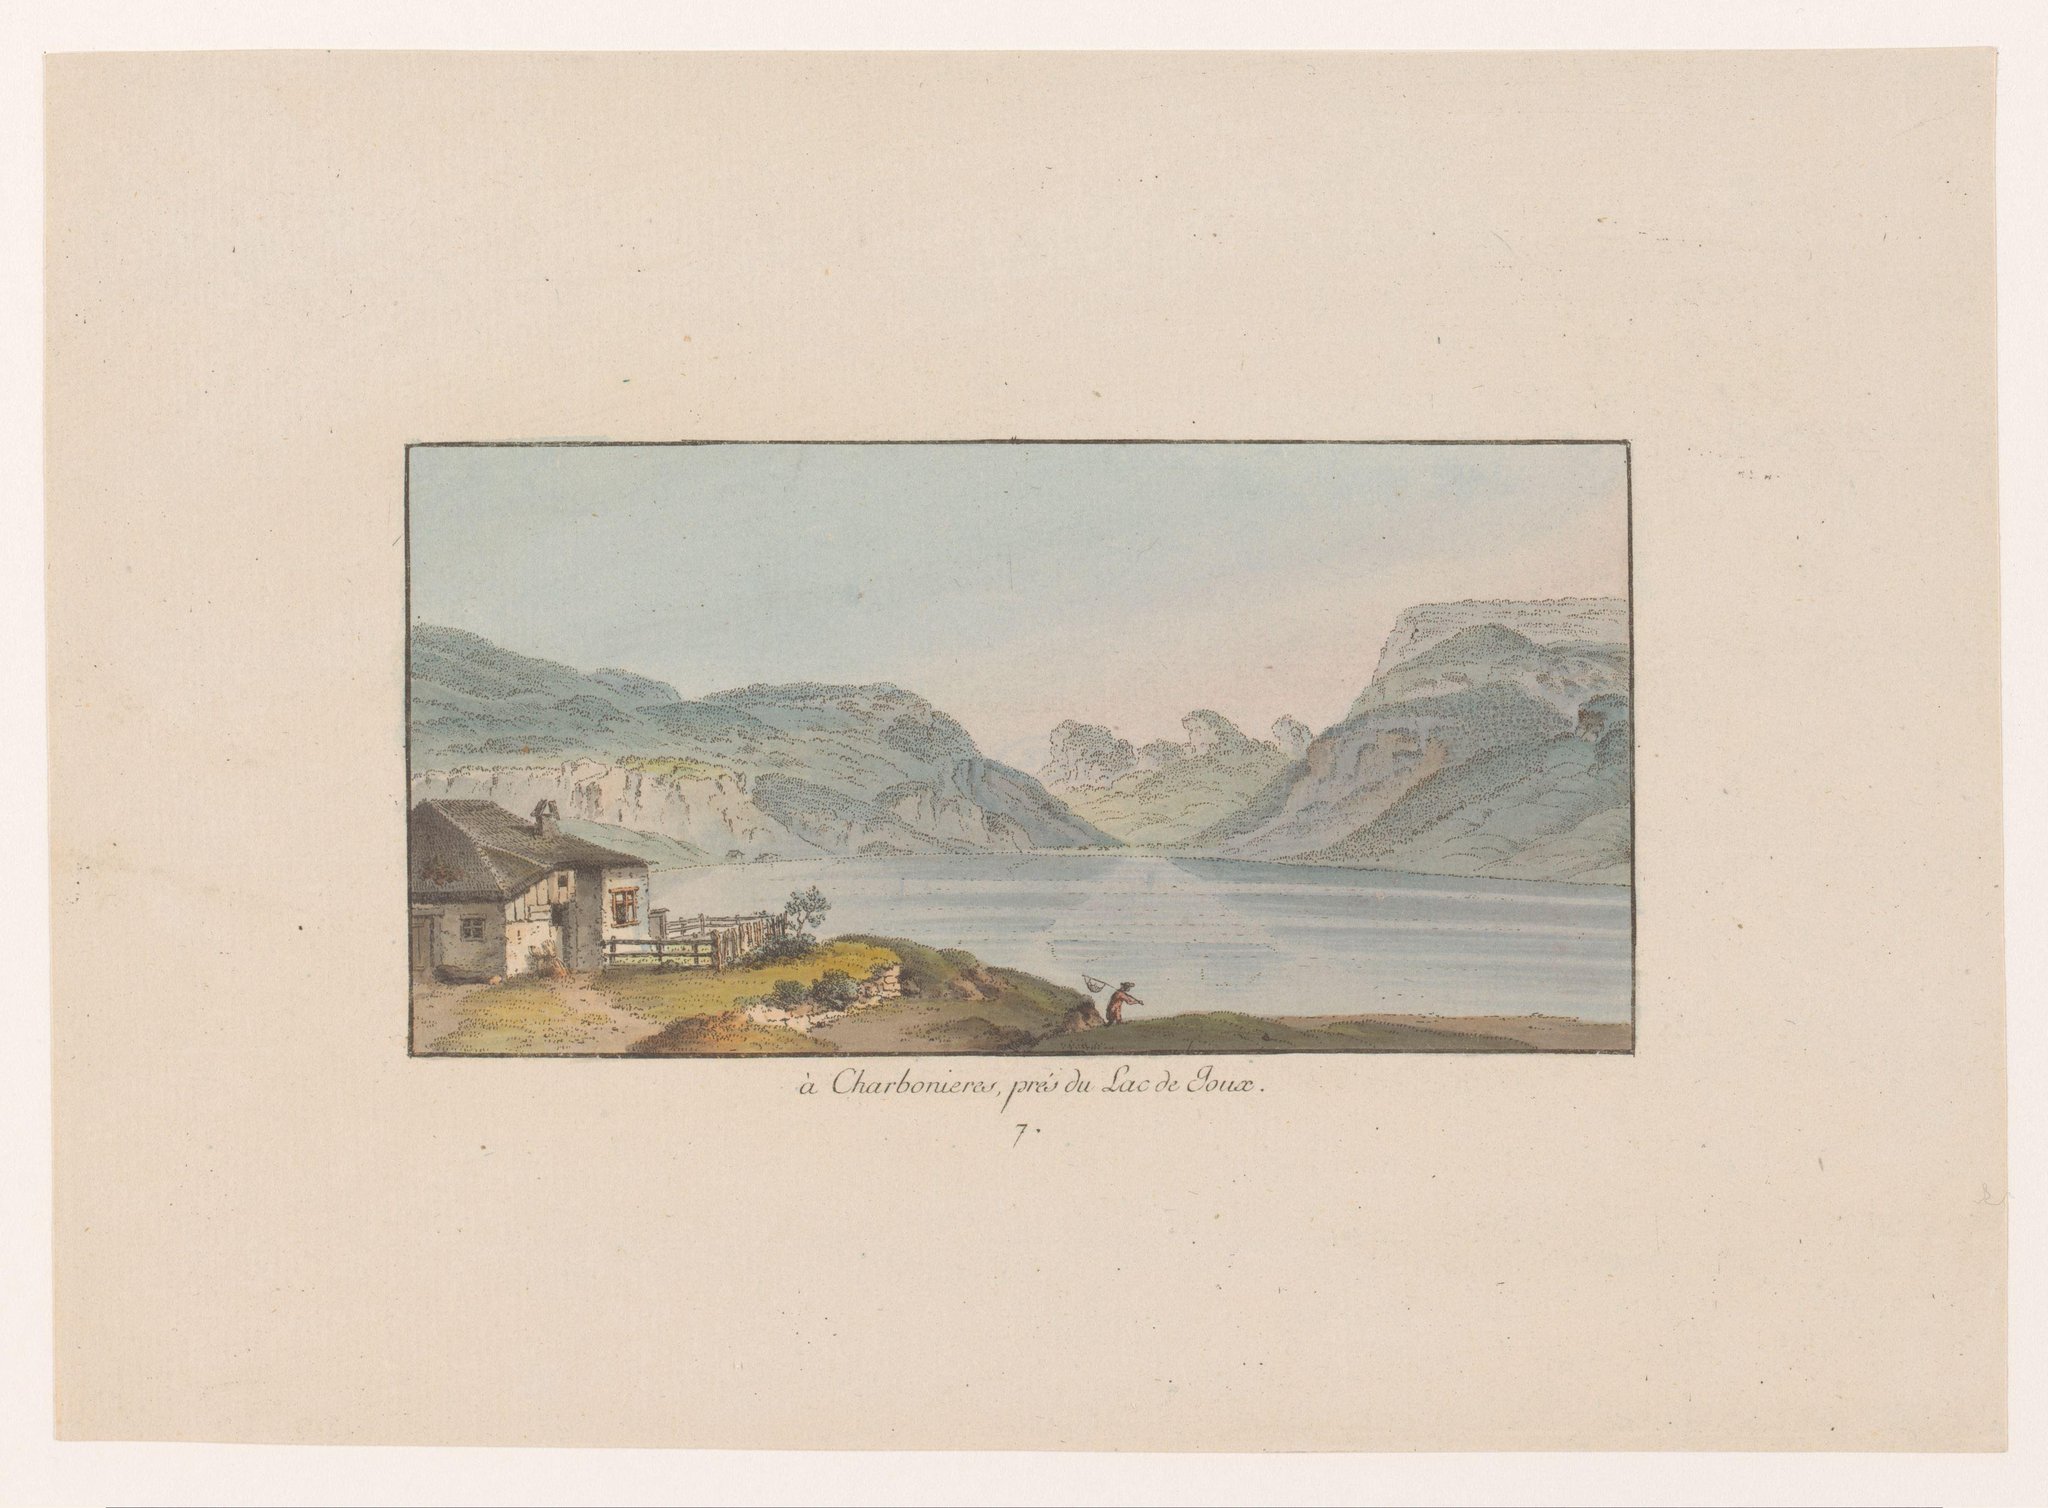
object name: print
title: Gezichten op Zwitserland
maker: heinrich rieter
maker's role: print maker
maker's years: 1751-1818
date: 1782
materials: paper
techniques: etching, hand coloring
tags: lake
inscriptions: watermark, collector's mark: Lugt 2228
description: Maakt deel uit van een serie met gezichten op Zwitserland.